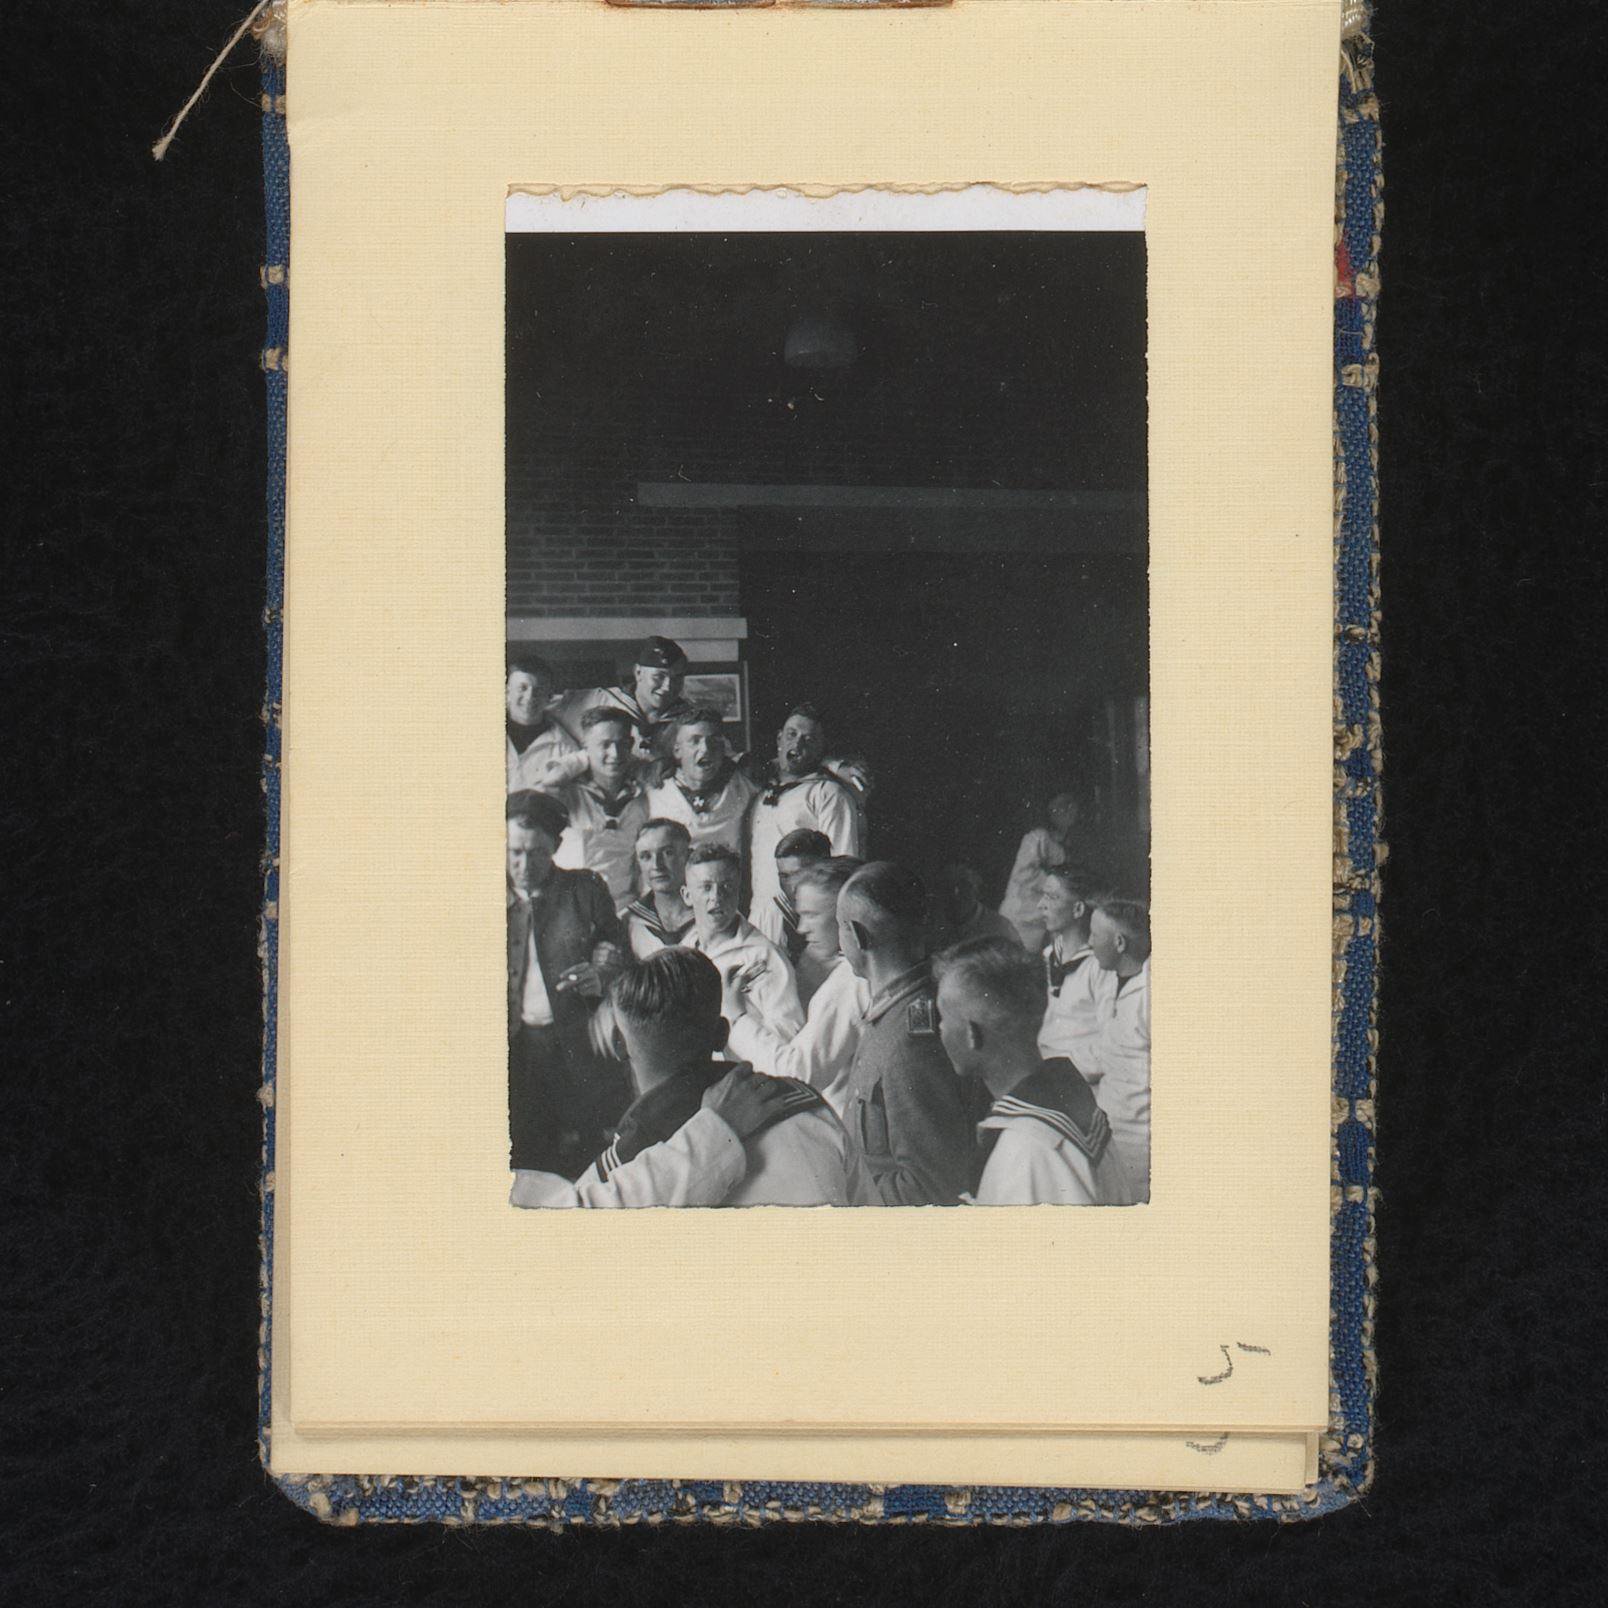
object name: photograph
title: Matrozen vieren feest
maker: Anonymous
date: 1940-1943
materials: photographic support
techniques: gelatin silver print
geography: netherlands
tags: the company, the unit, the troop ~ military service, sailor, recreation ~ the soldier off duty, netherlands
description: Zingende en feestende Duitse matrozen in wit uniform. Onderdeel van het fotoalbum over de Kriegsmarine 1940-1943.